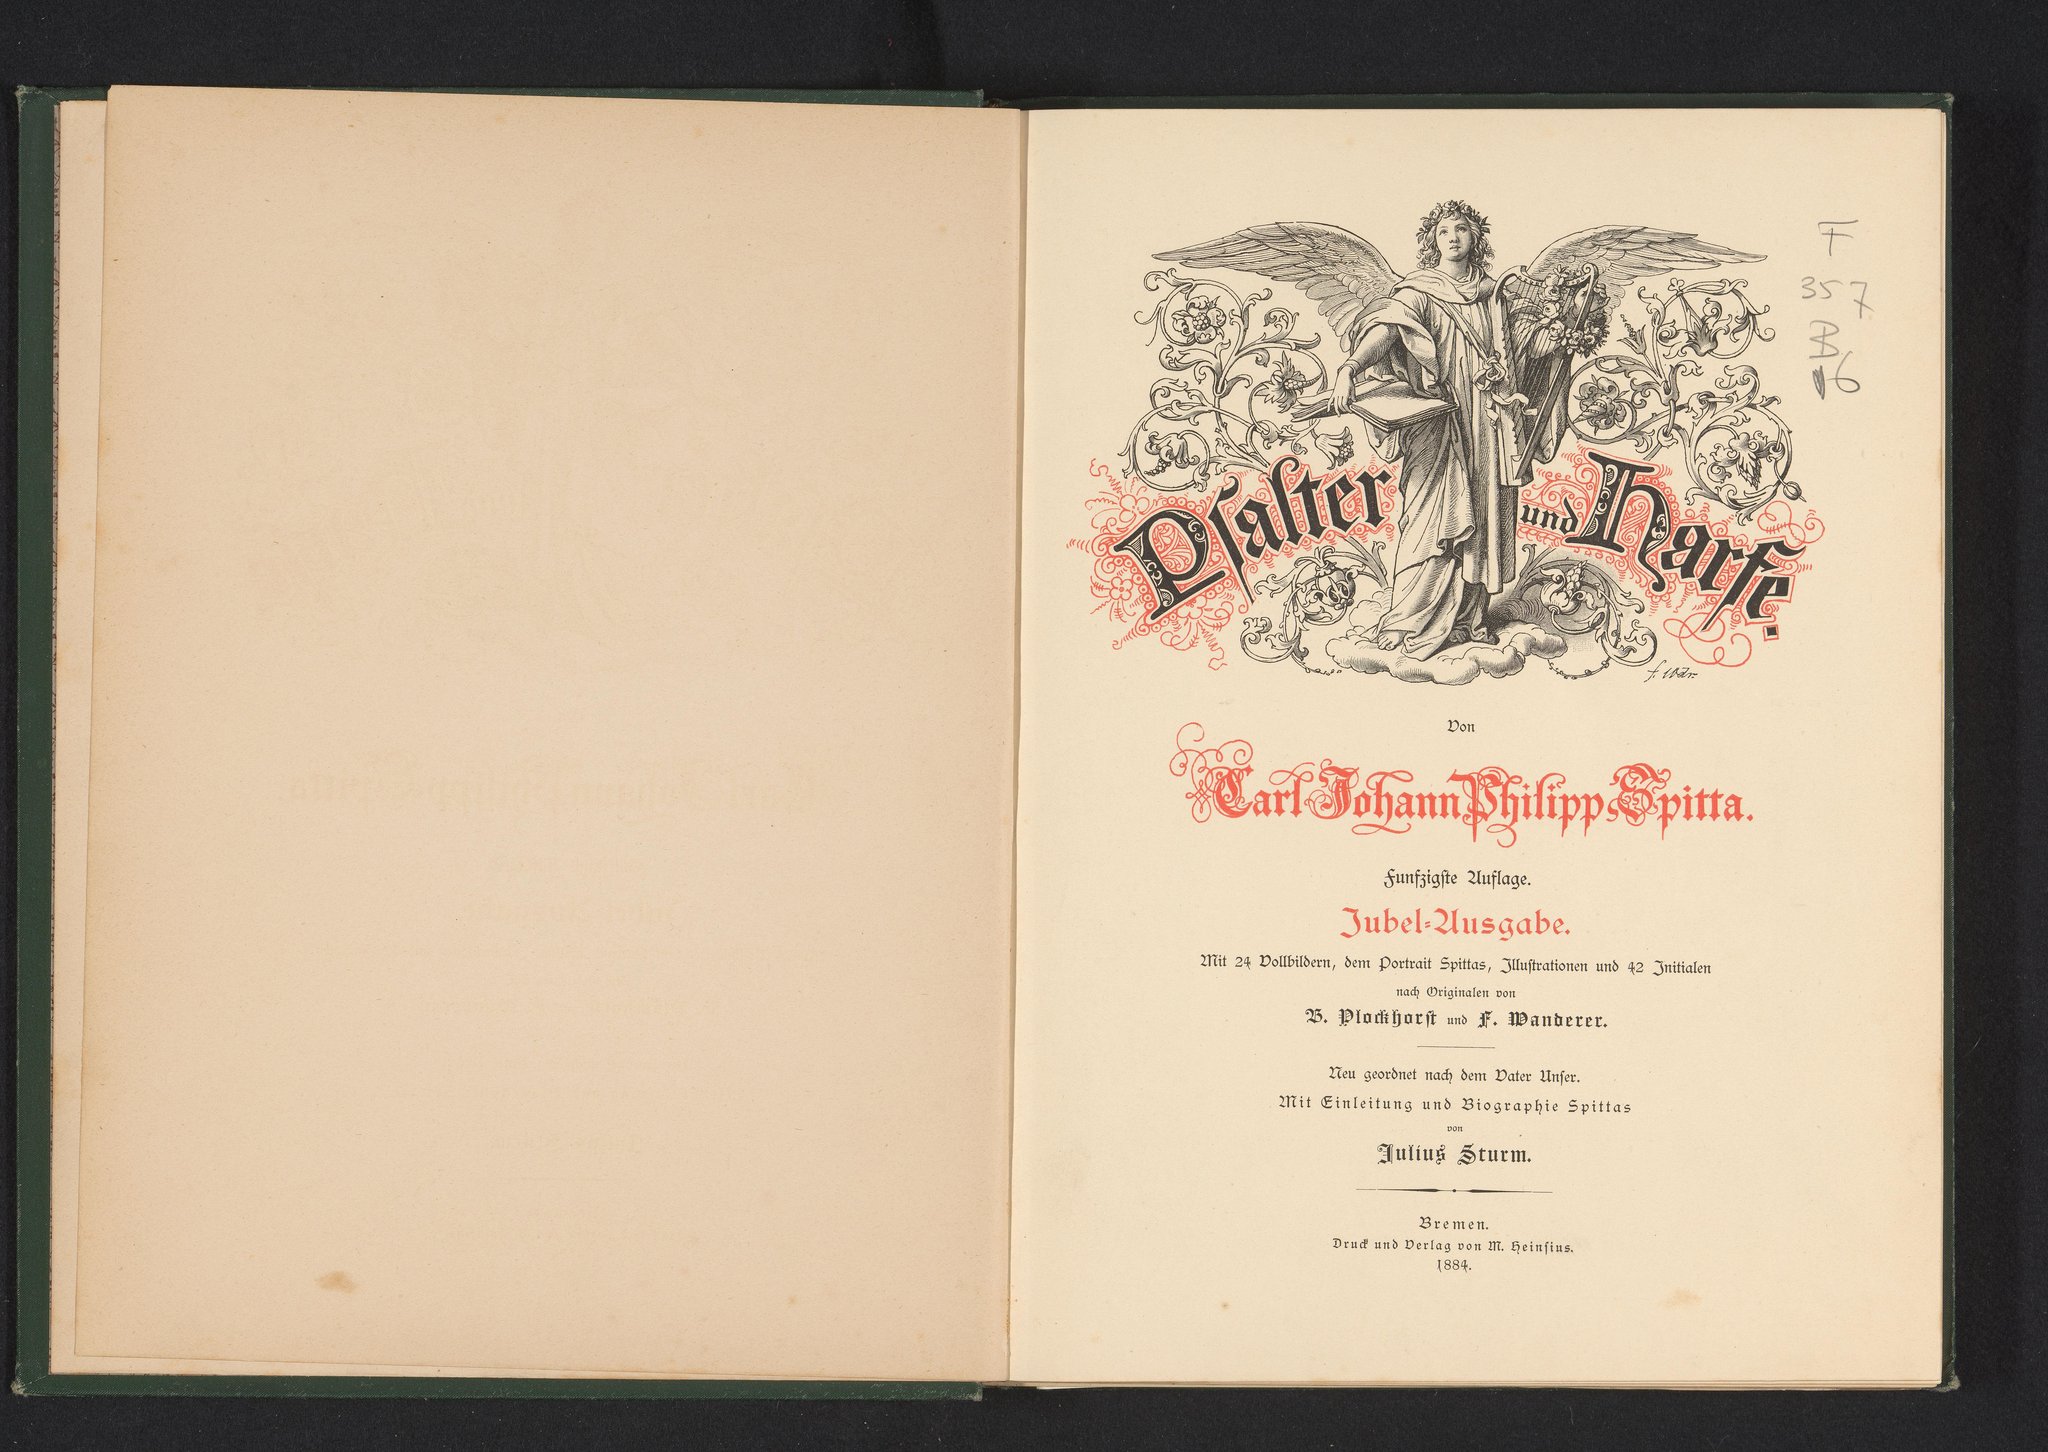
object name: book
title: Psalter und Harfe Jubel-Ausgabe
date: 1884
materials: cardboard, linen, paper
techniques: photograph, printing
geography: bremen